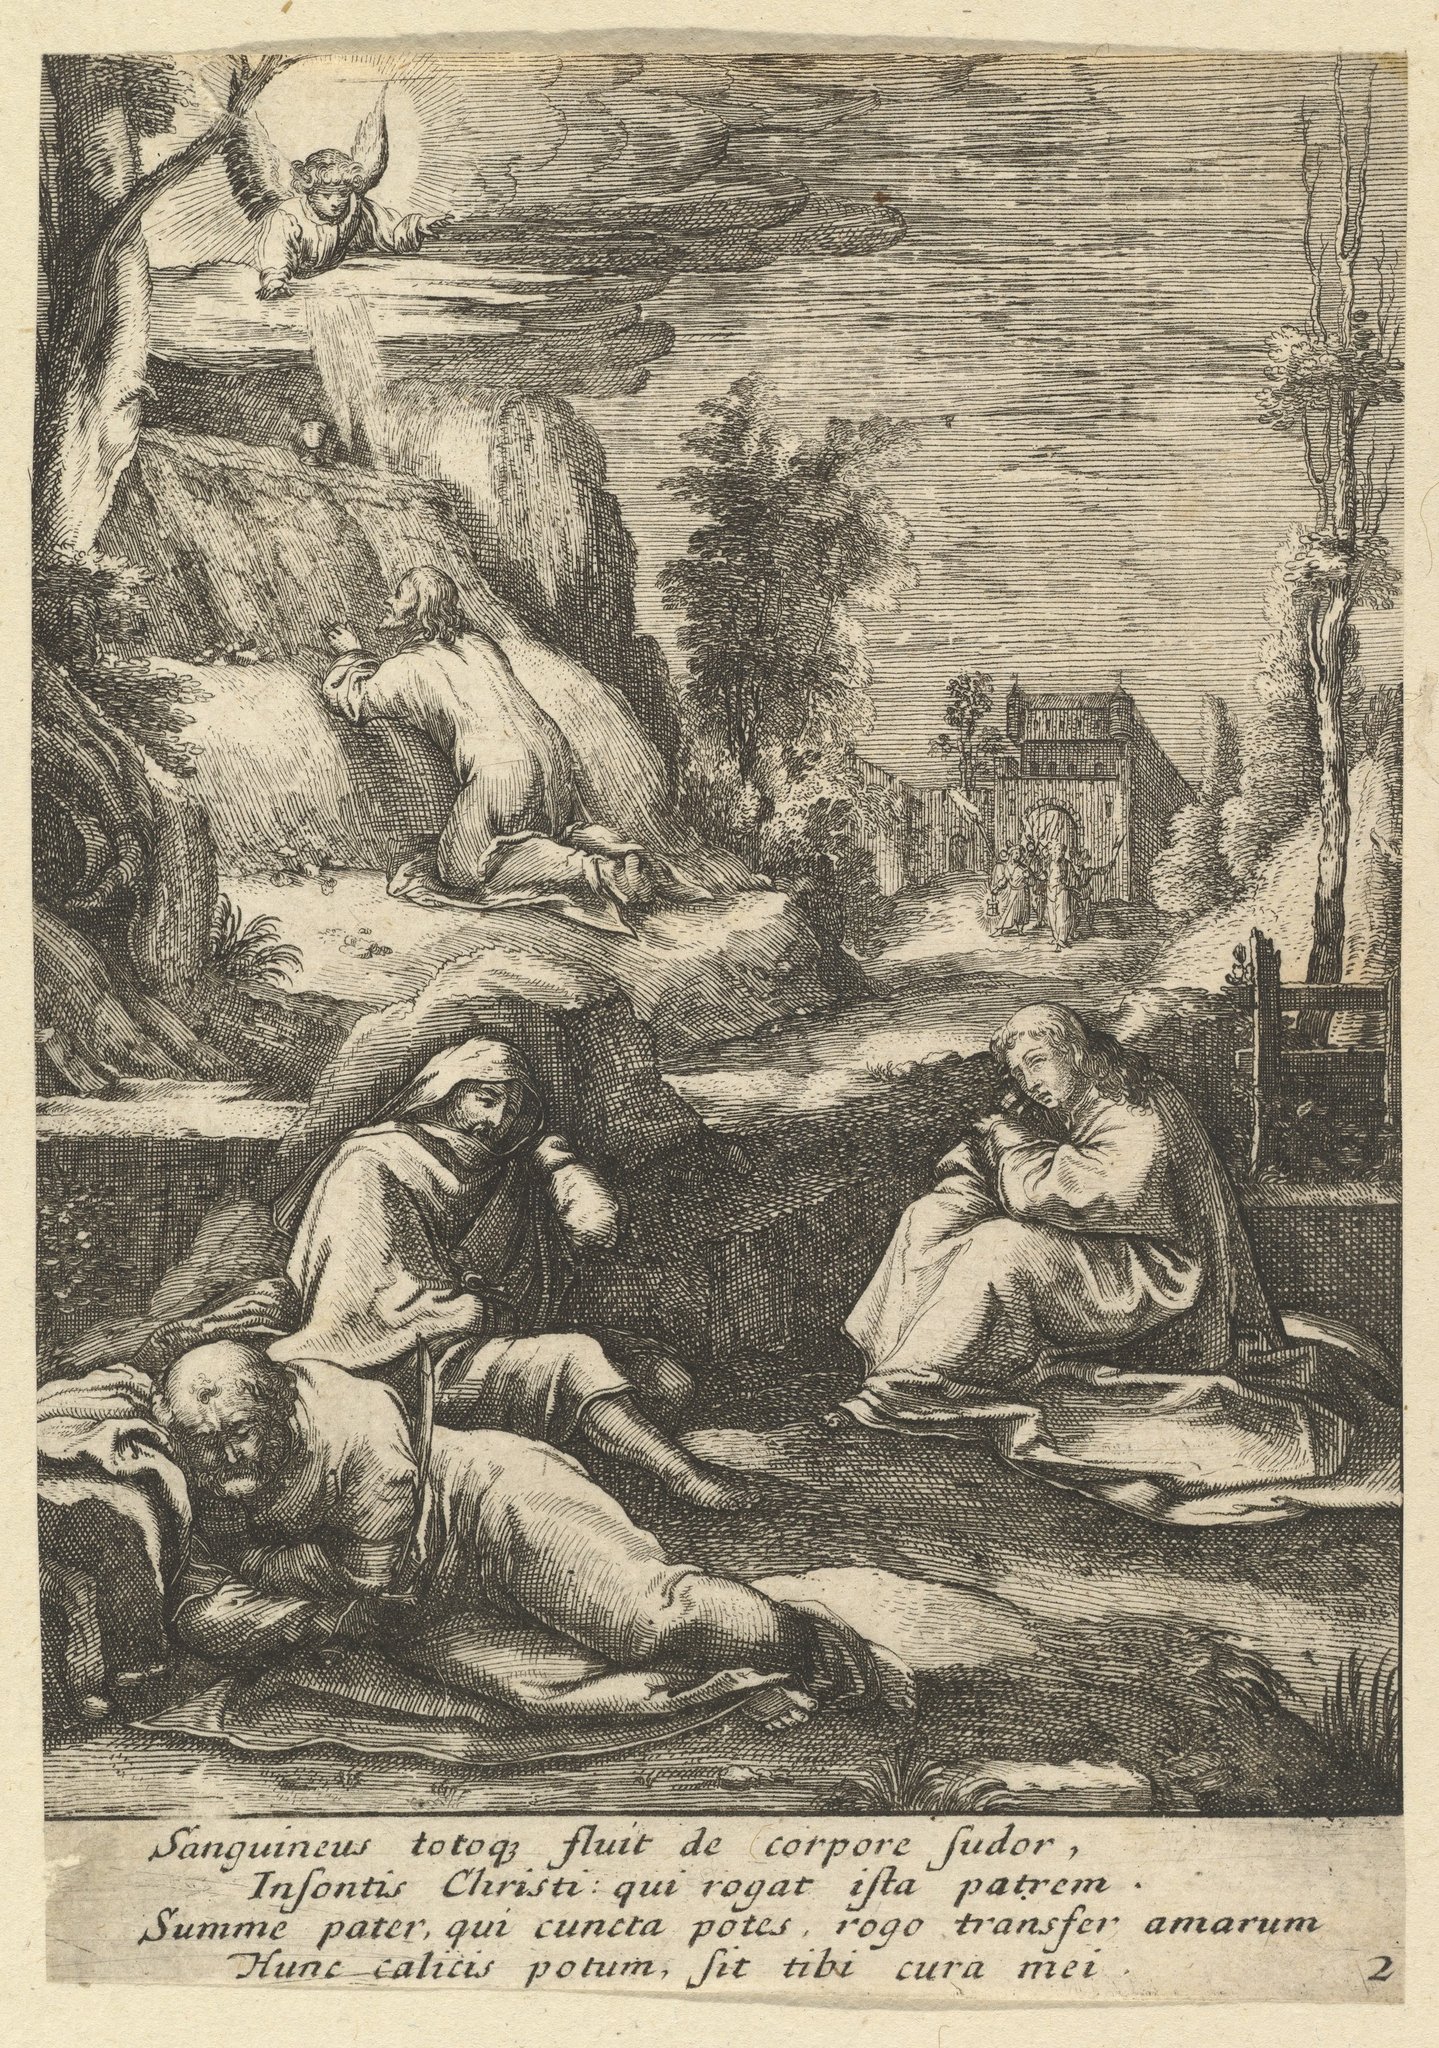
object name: print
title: The Agony in the Garden, from "The Passion of Christ"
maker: nicolas cochin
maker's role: artist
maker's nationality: french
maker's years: 1610-1686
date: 1634-1666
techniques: etching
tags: sleeping,men,women,angels,christ